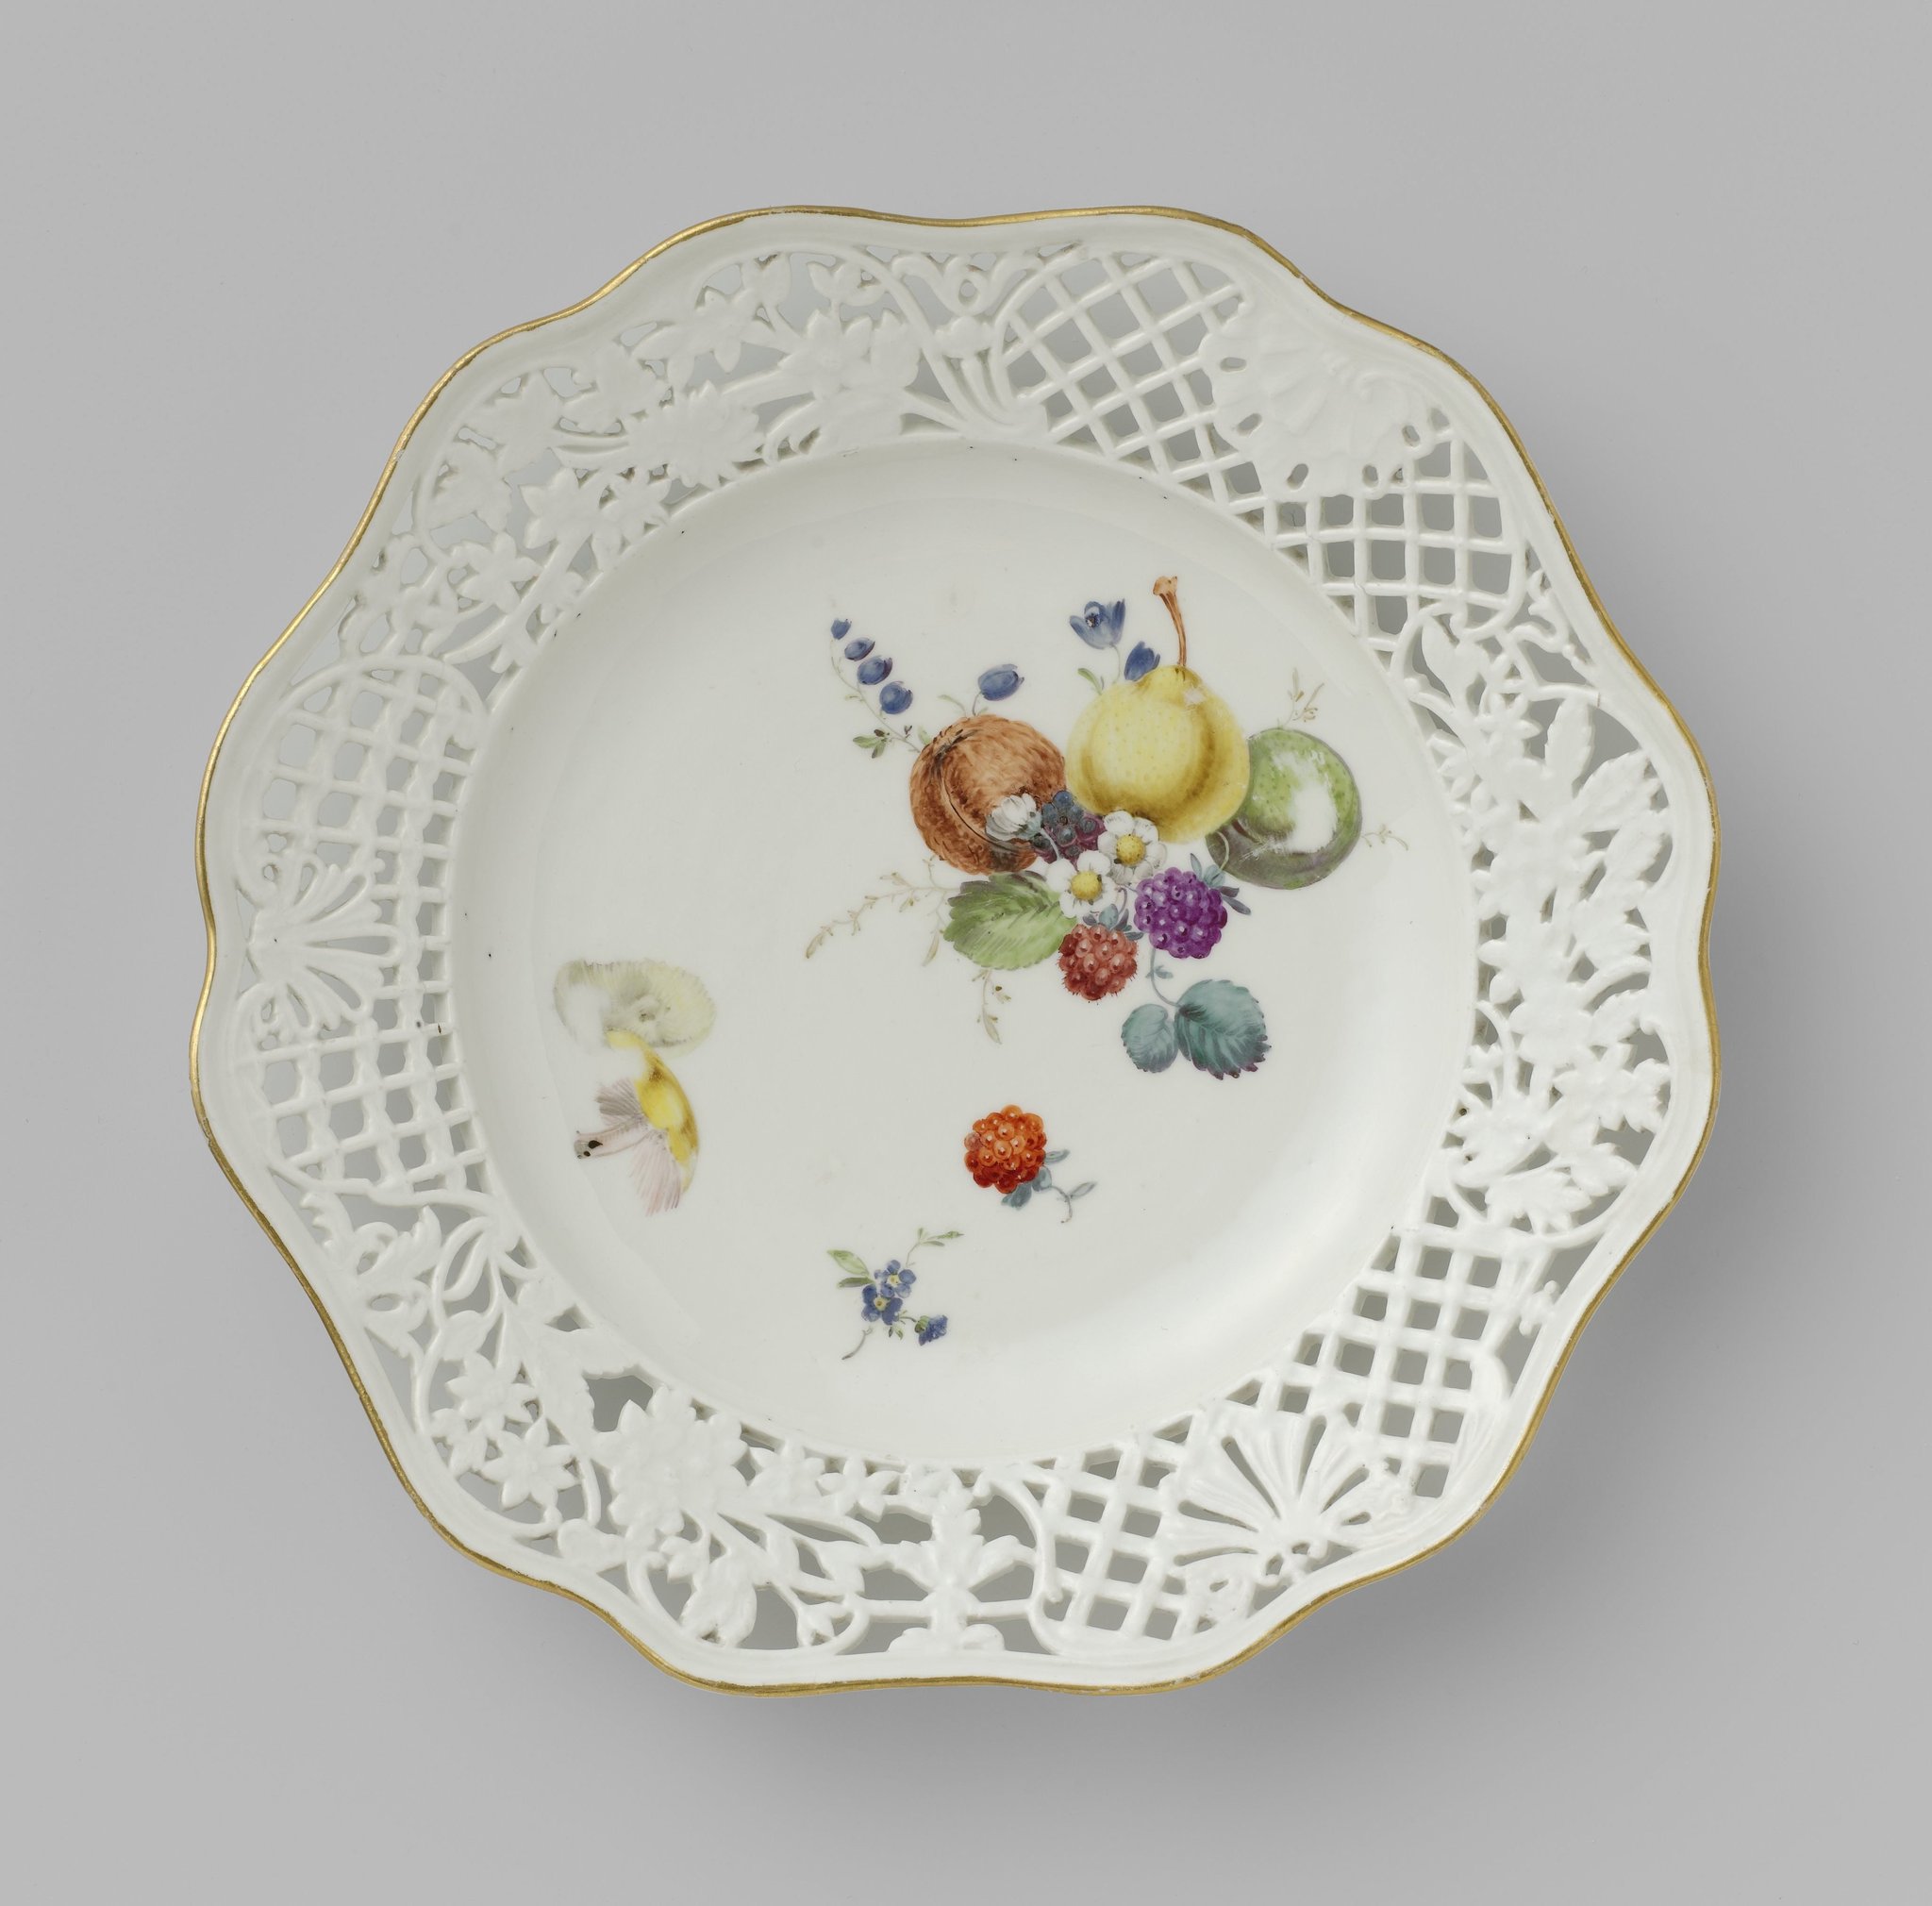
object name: dessert plate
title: Dessertbord, veelkleurig beschilderd met bloemen en vruchten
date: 1750-1760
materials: porcelain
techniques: painted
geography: meissen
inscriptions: factory mark, mold mark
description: Rond dessertbord van beschilderd porselein. De geschulpte rand is opengewerkt met afwisselend een netwerk met een palmet en takken met bladeren en bloemen. De spiegel is beschilderd met bloemen en vruchten. Het bord is gemerkt.